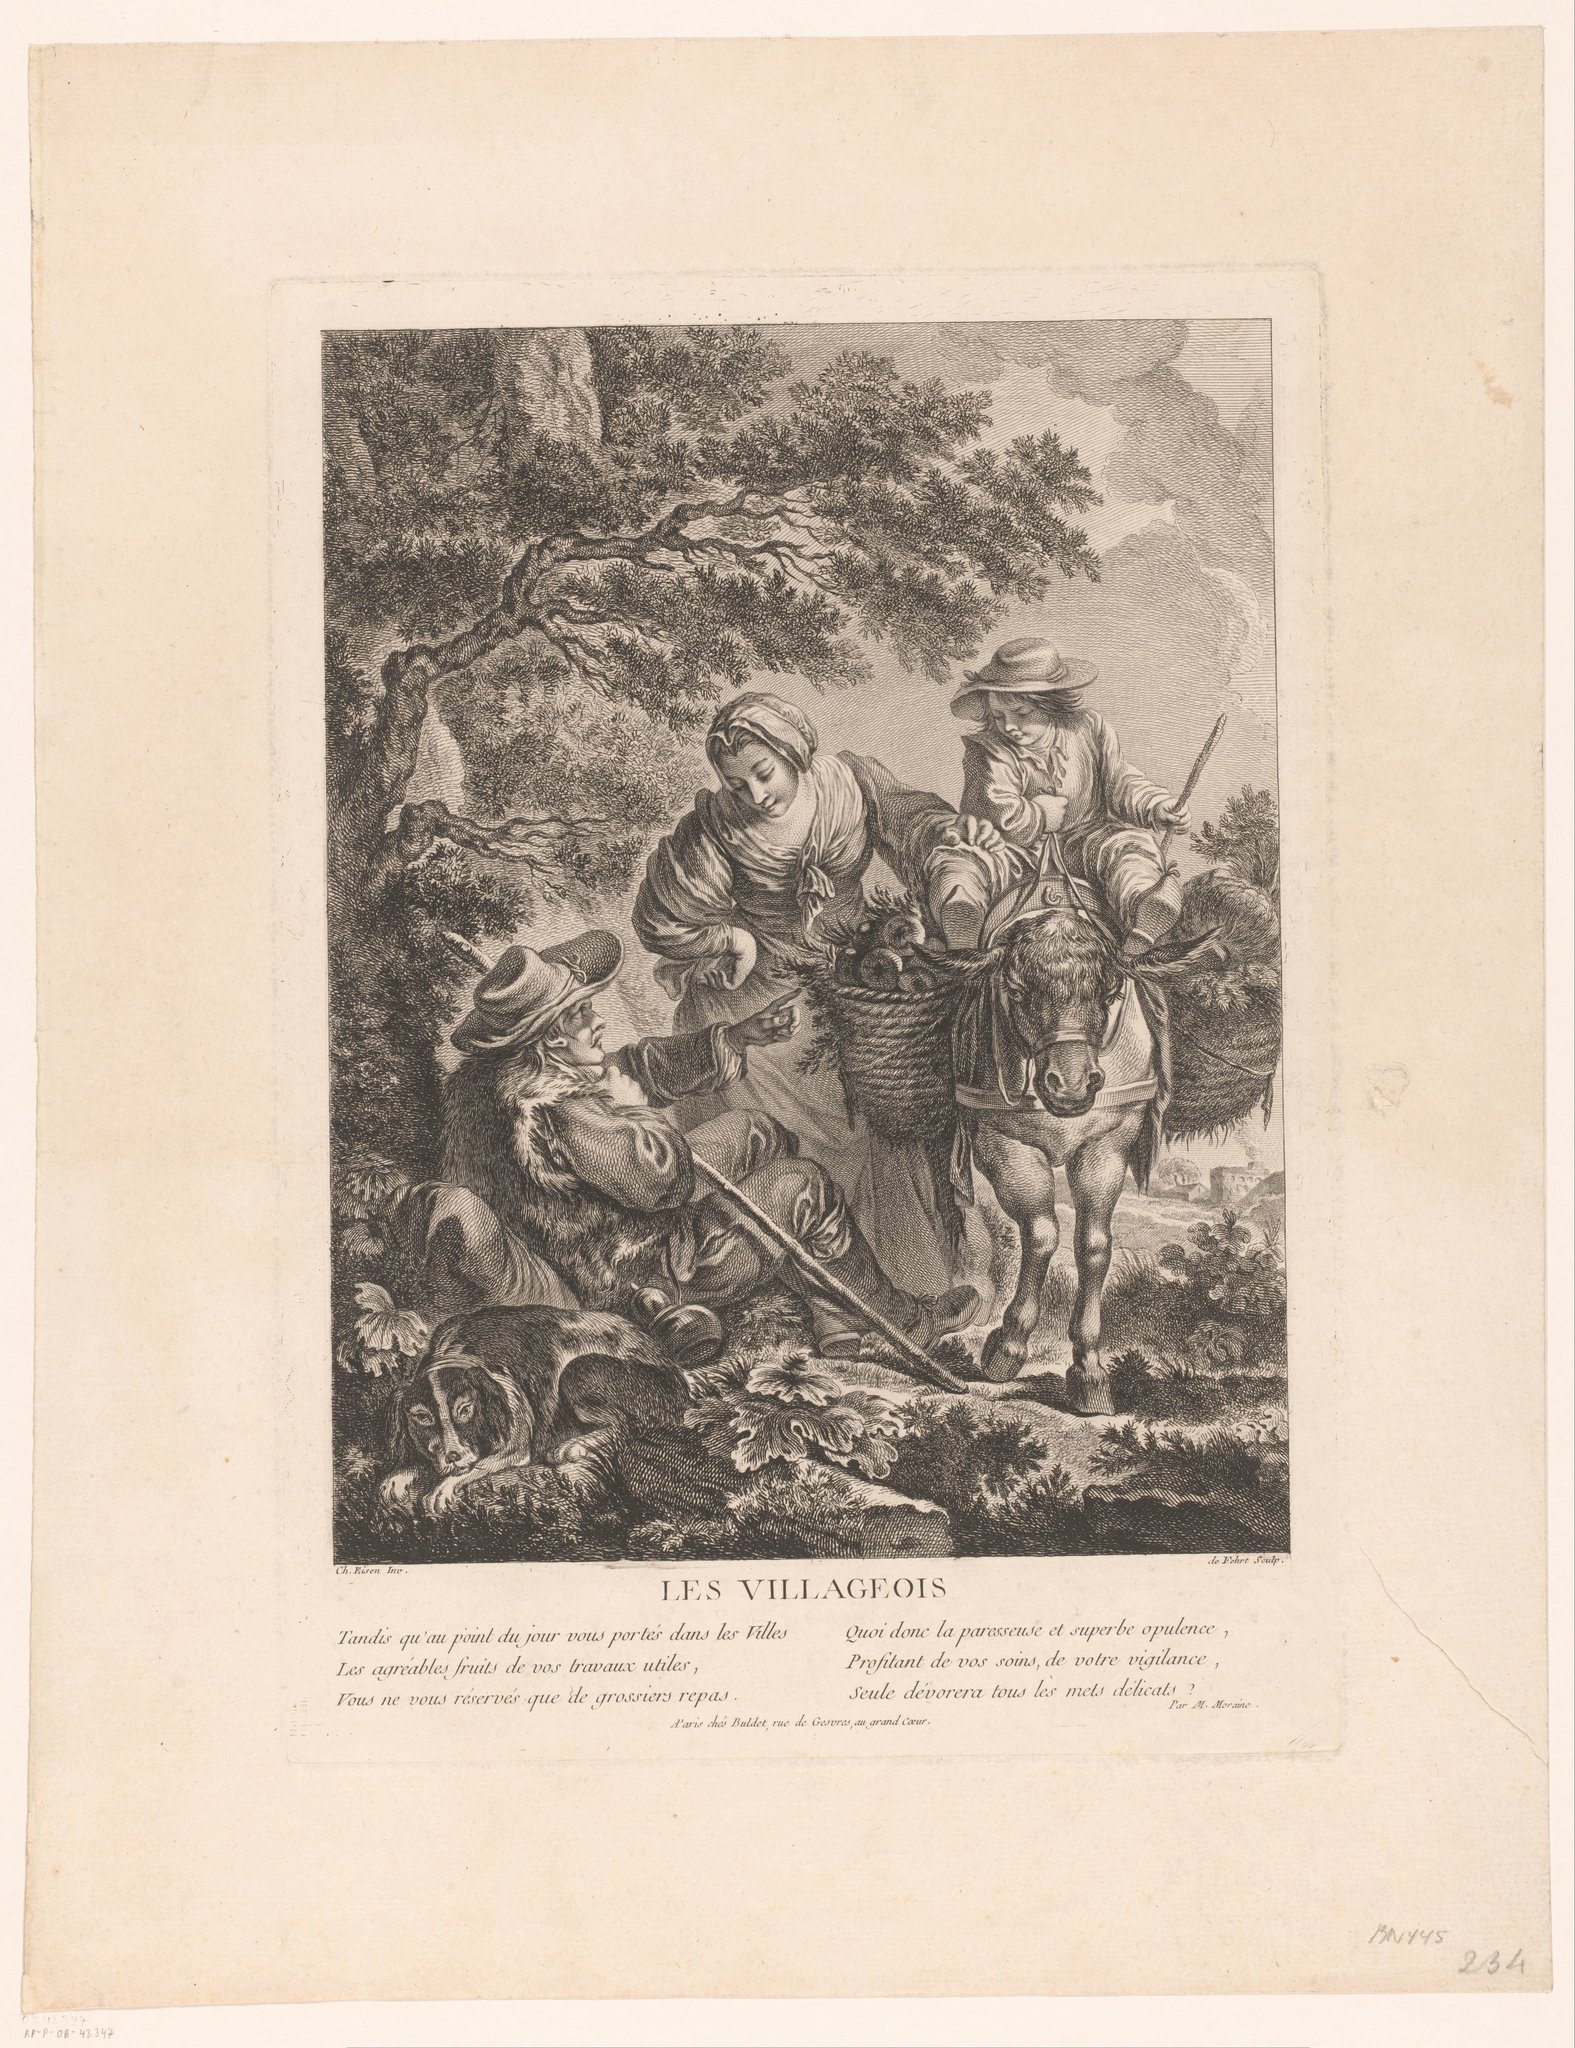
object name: print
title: Dorpelingen met ezel houden halt bij herder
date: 1733-1774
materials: paper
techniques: engraving, etching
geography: paris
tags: ass, donkey, herding, herdsman, herdswoman, shepherd, shepherdess, cowherd, etc.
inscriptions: collector's mark: Lugt 2228